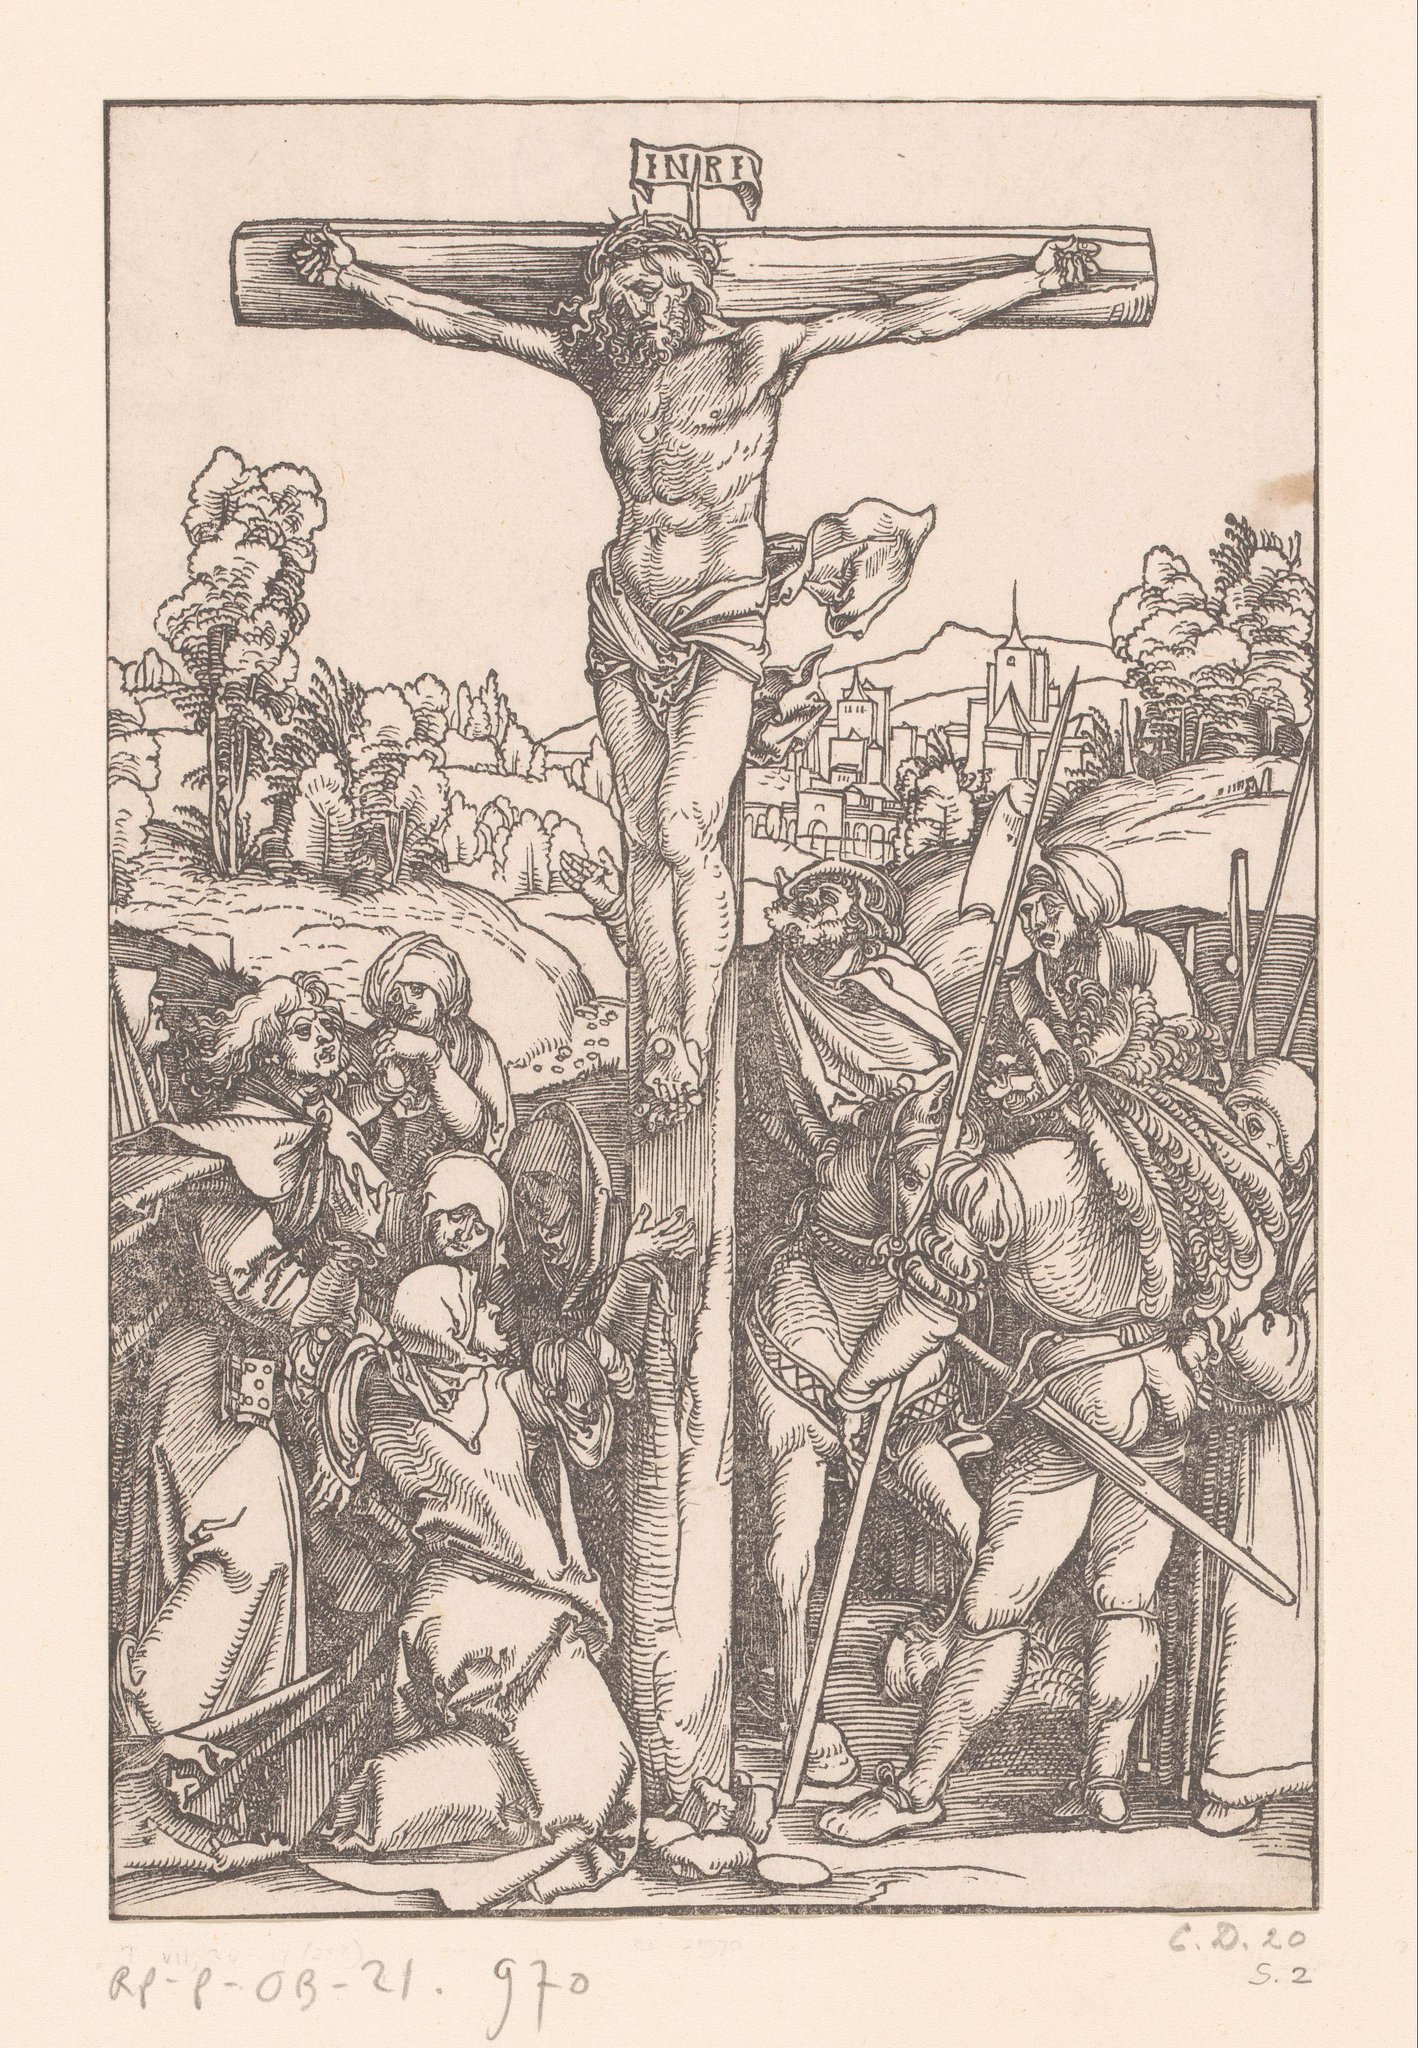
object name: book illustration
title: Christus aan het kruis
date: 1505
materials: paper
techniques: woodcut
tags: comprehensive representations of the events on golgotha during christ's hanging on the cross, no particular event emphasized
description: Prent voor het eerst gebruikt in: Pinder, Ulrich. Des beschlossen gart des rosenkranzes marie. Neurenberg: Friedrich Peypus, 1505.